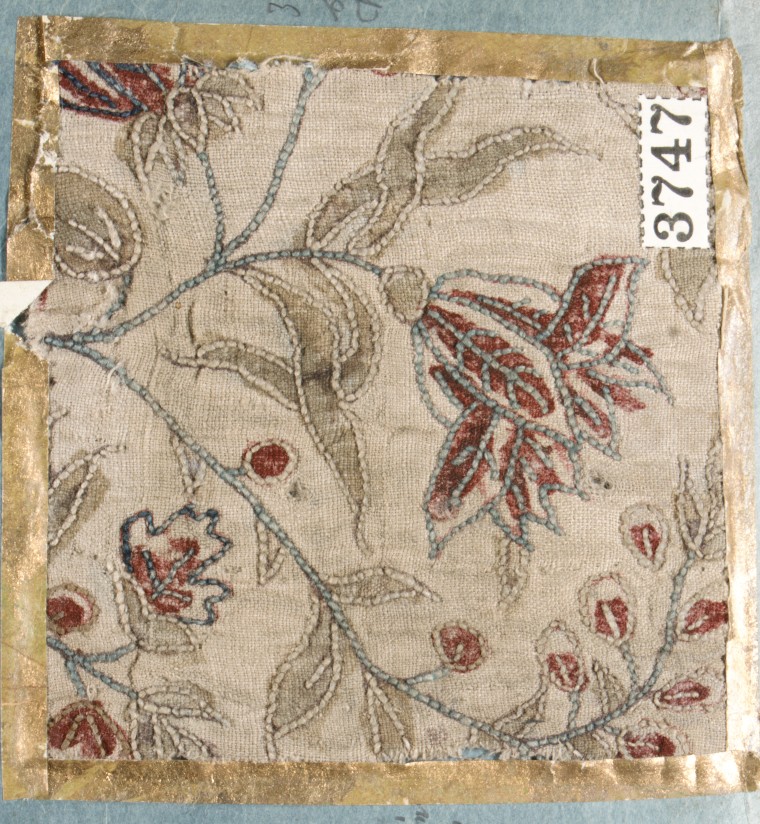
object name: sample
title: Textile Sample from Sample Book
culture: japanese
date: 1801-1900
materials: silk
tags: flowers